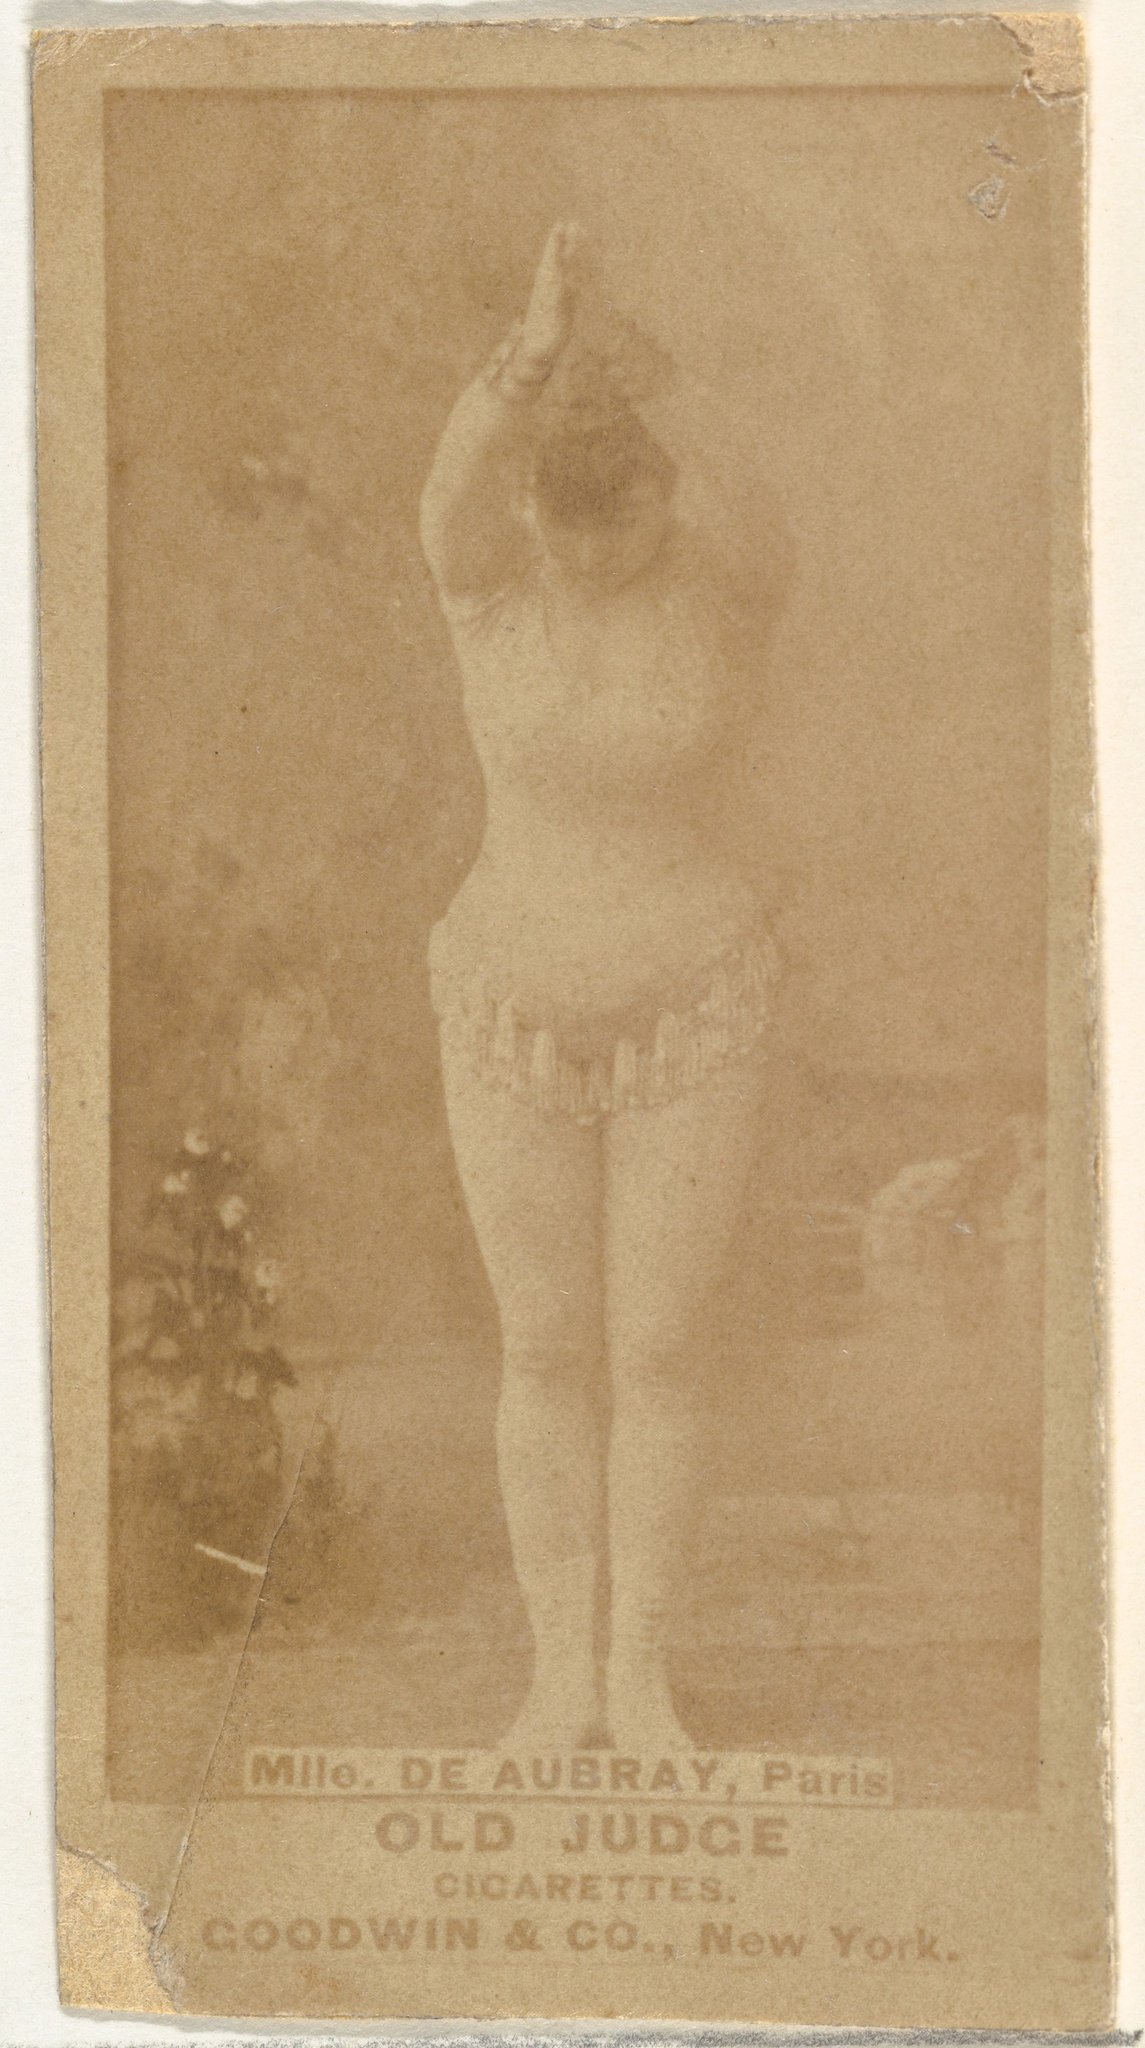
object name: photograph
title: Mlle. De Aubray, Paris, from the Actors and Actresses series (N171) for Old Judge Cigarettes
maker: goodwin & company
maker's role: publisher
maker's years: 1850-1950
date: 1886-1890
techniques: albumen silver print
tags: portraits,women,actresses